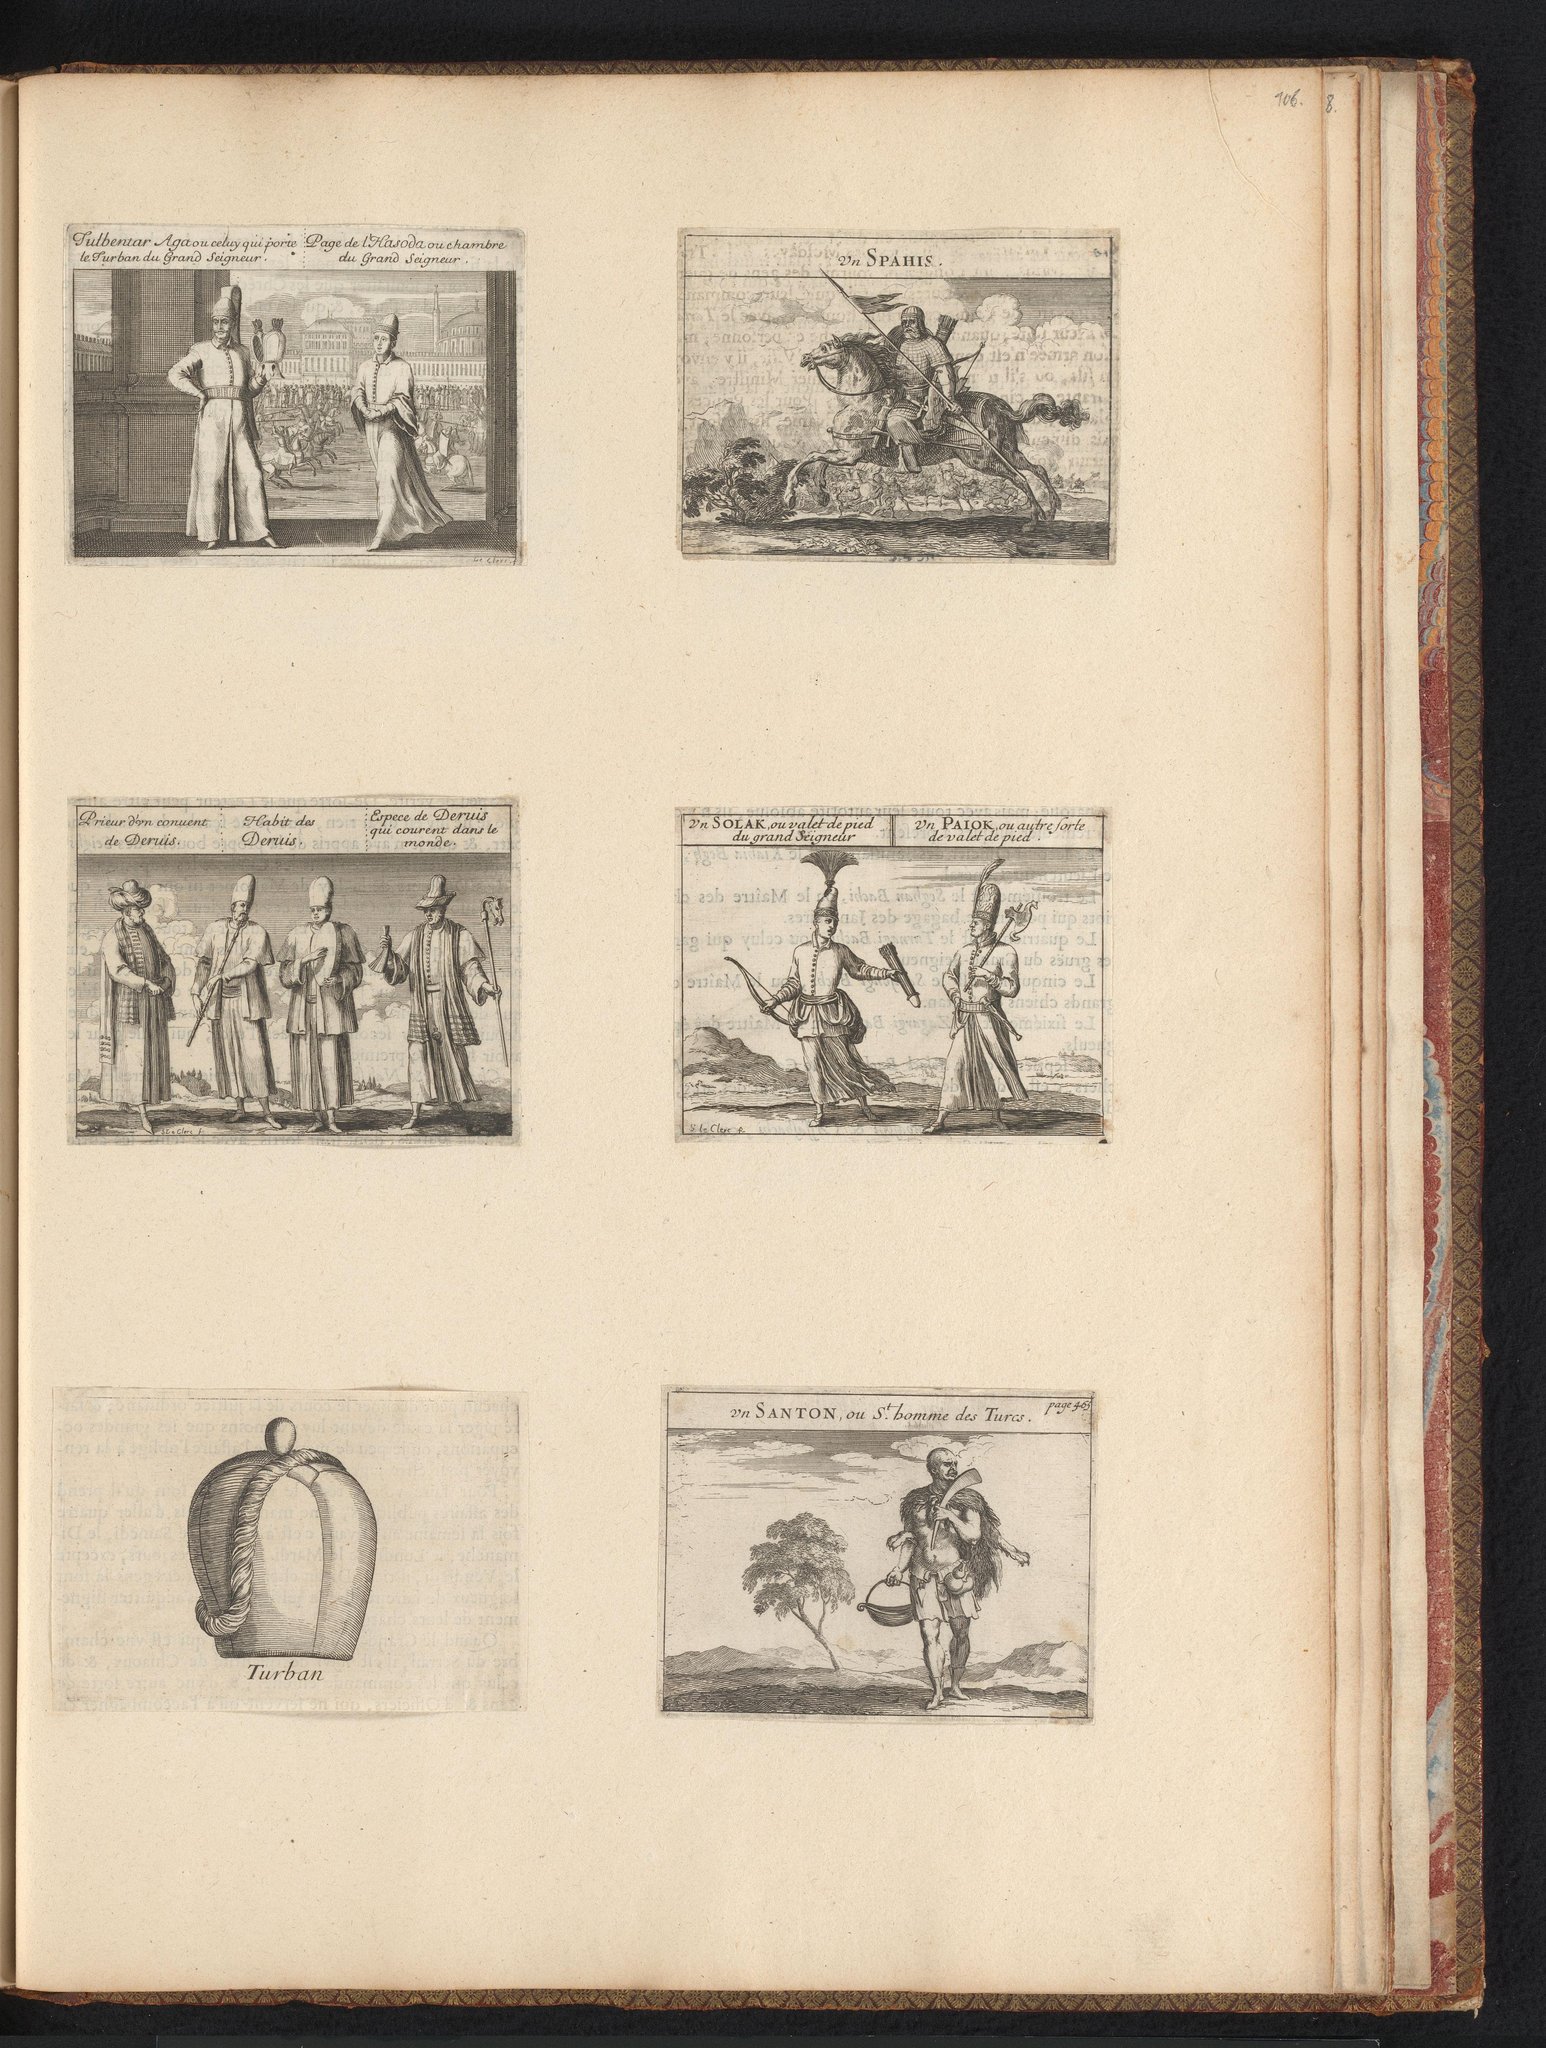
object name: print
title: Personen uit het Ottomaanse Rijk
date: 1670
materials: paper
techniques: engraving, etching, letterpress printing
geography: paris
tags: ranks in the army, non-christian religions (including institutions, customs and antiquities), head-gear: turban, house personnel, servants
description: Prenten uit: Rycaut, Paul. Histoire de l'état présent de l'Empire ottoman (...). Parijs: Sébastien Mabre-Cramoisy, 1670.